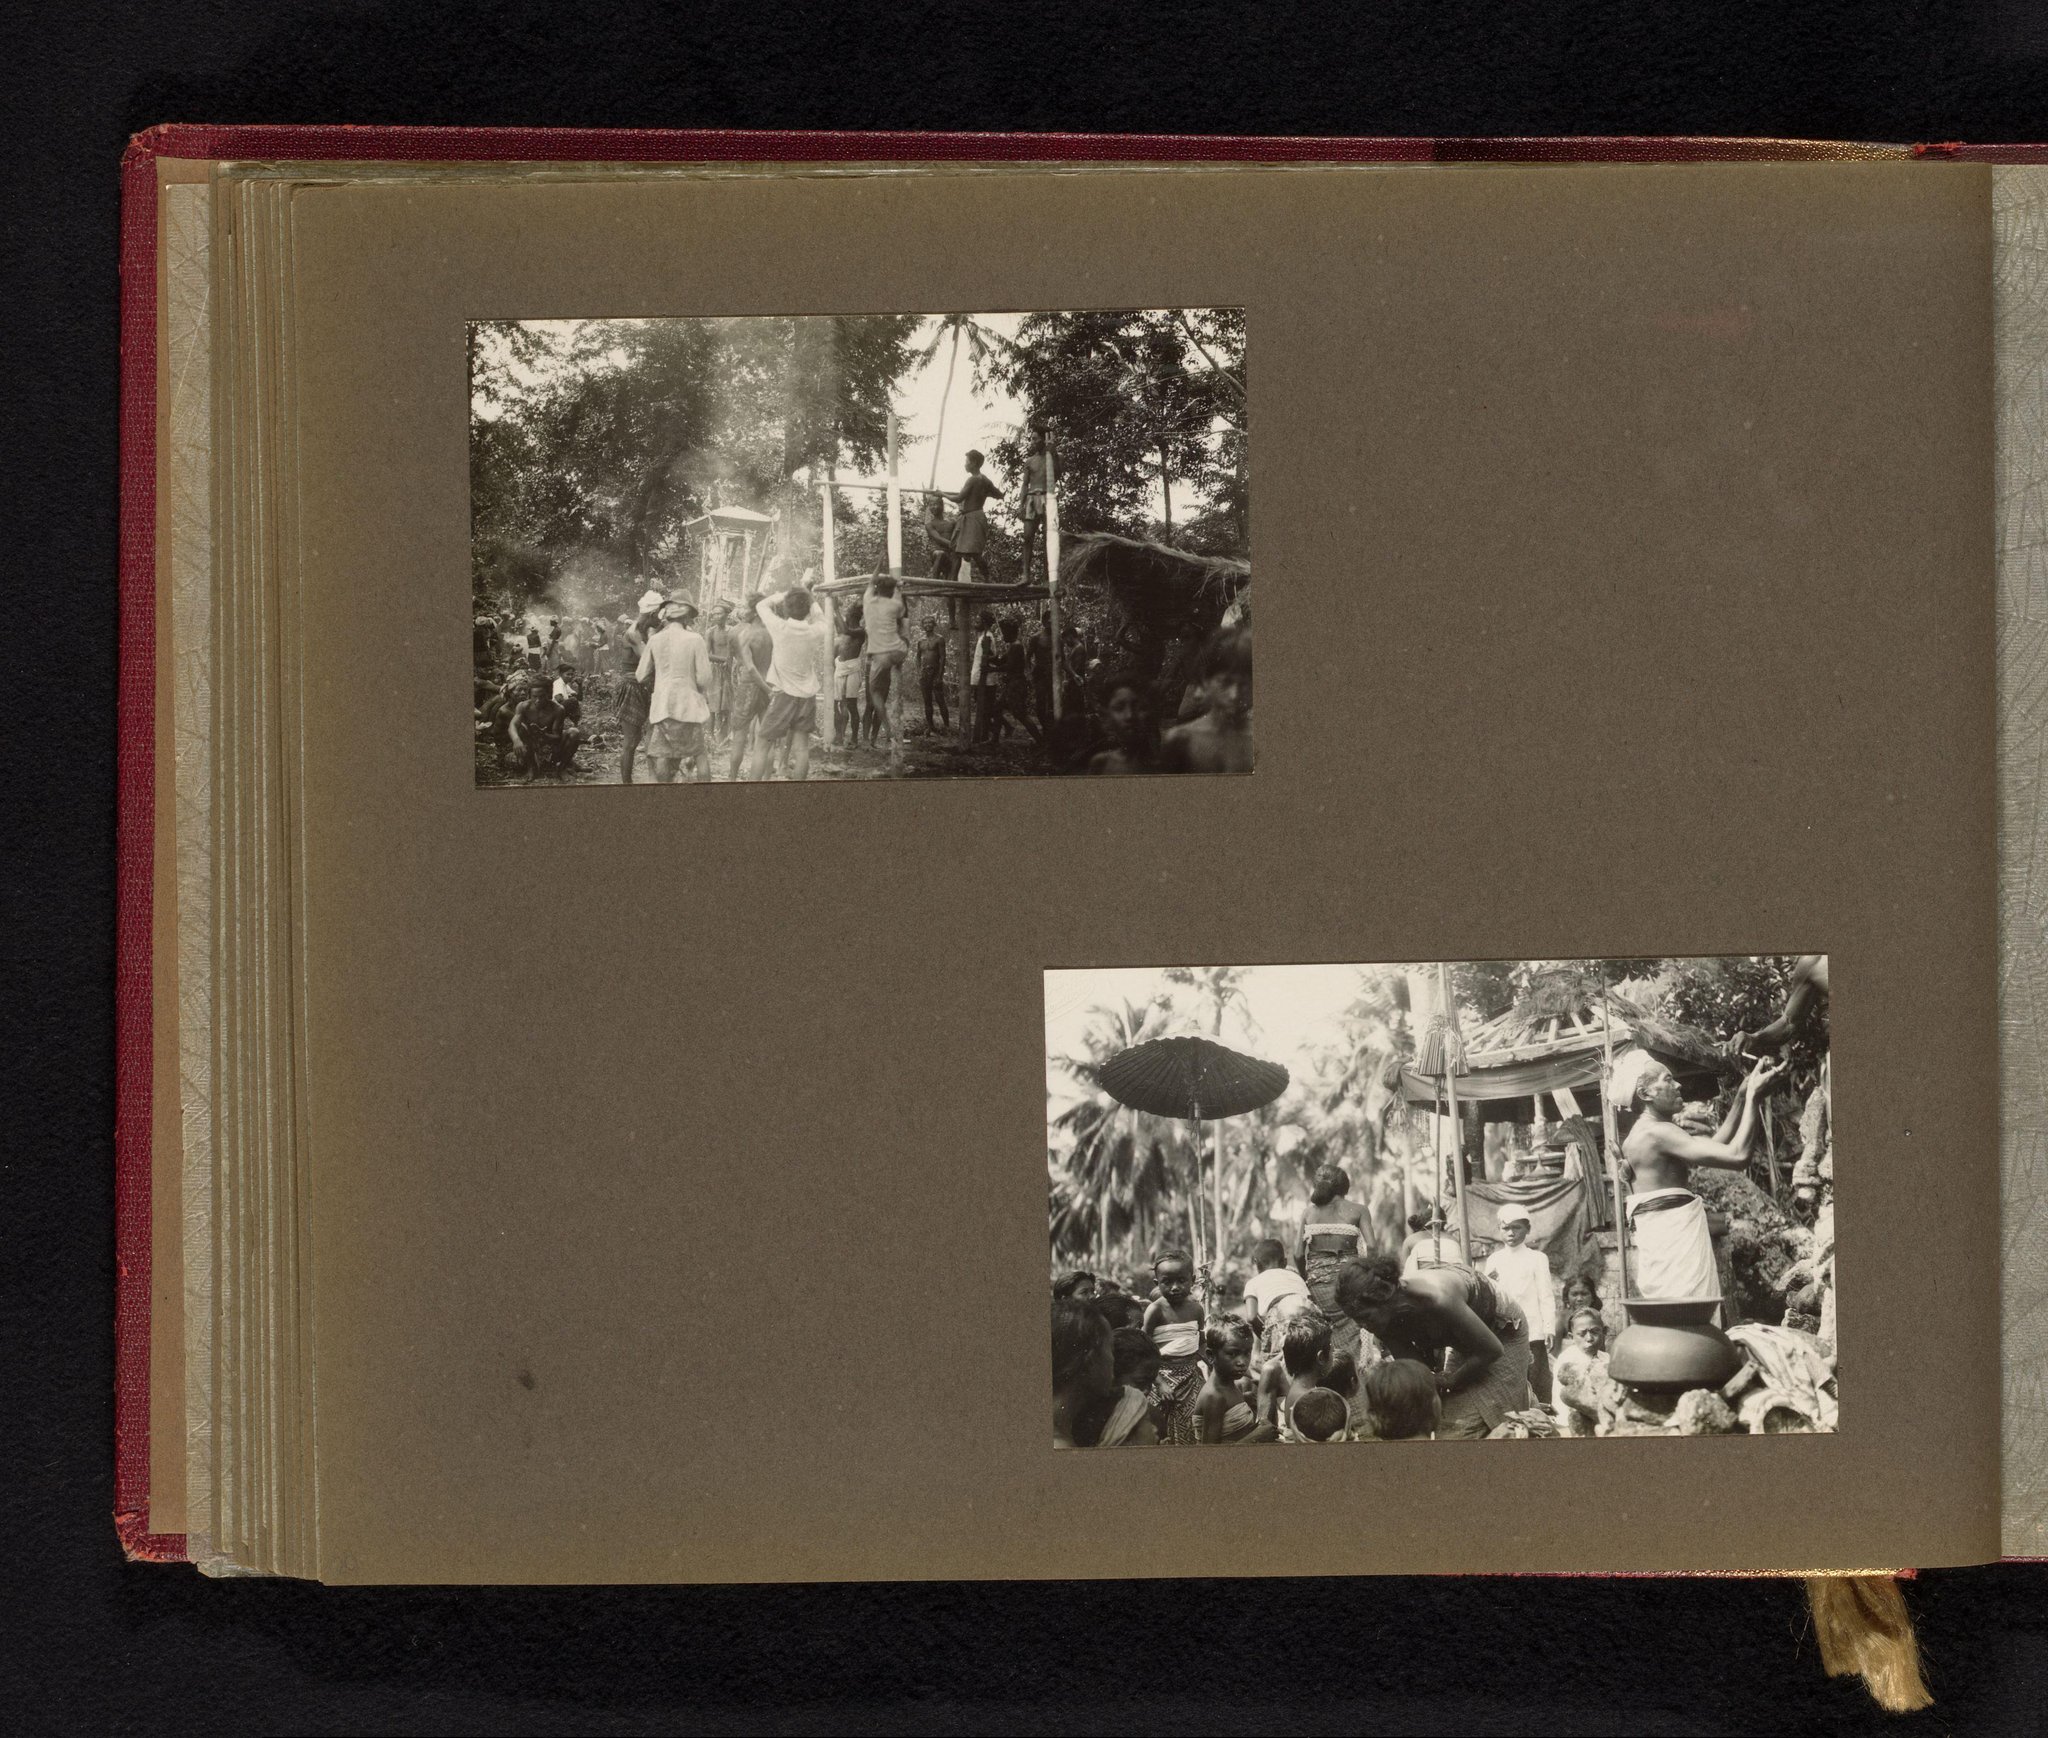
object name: album leaf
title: Twee opnamen van rituele gebruiken, mogelijk rond een uitvaart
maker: Anonymous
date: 1950-1960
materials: photographic support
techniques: gelatin silver print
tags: ritual practices ~ non-christian religions, historical persons, dutch east indies, the